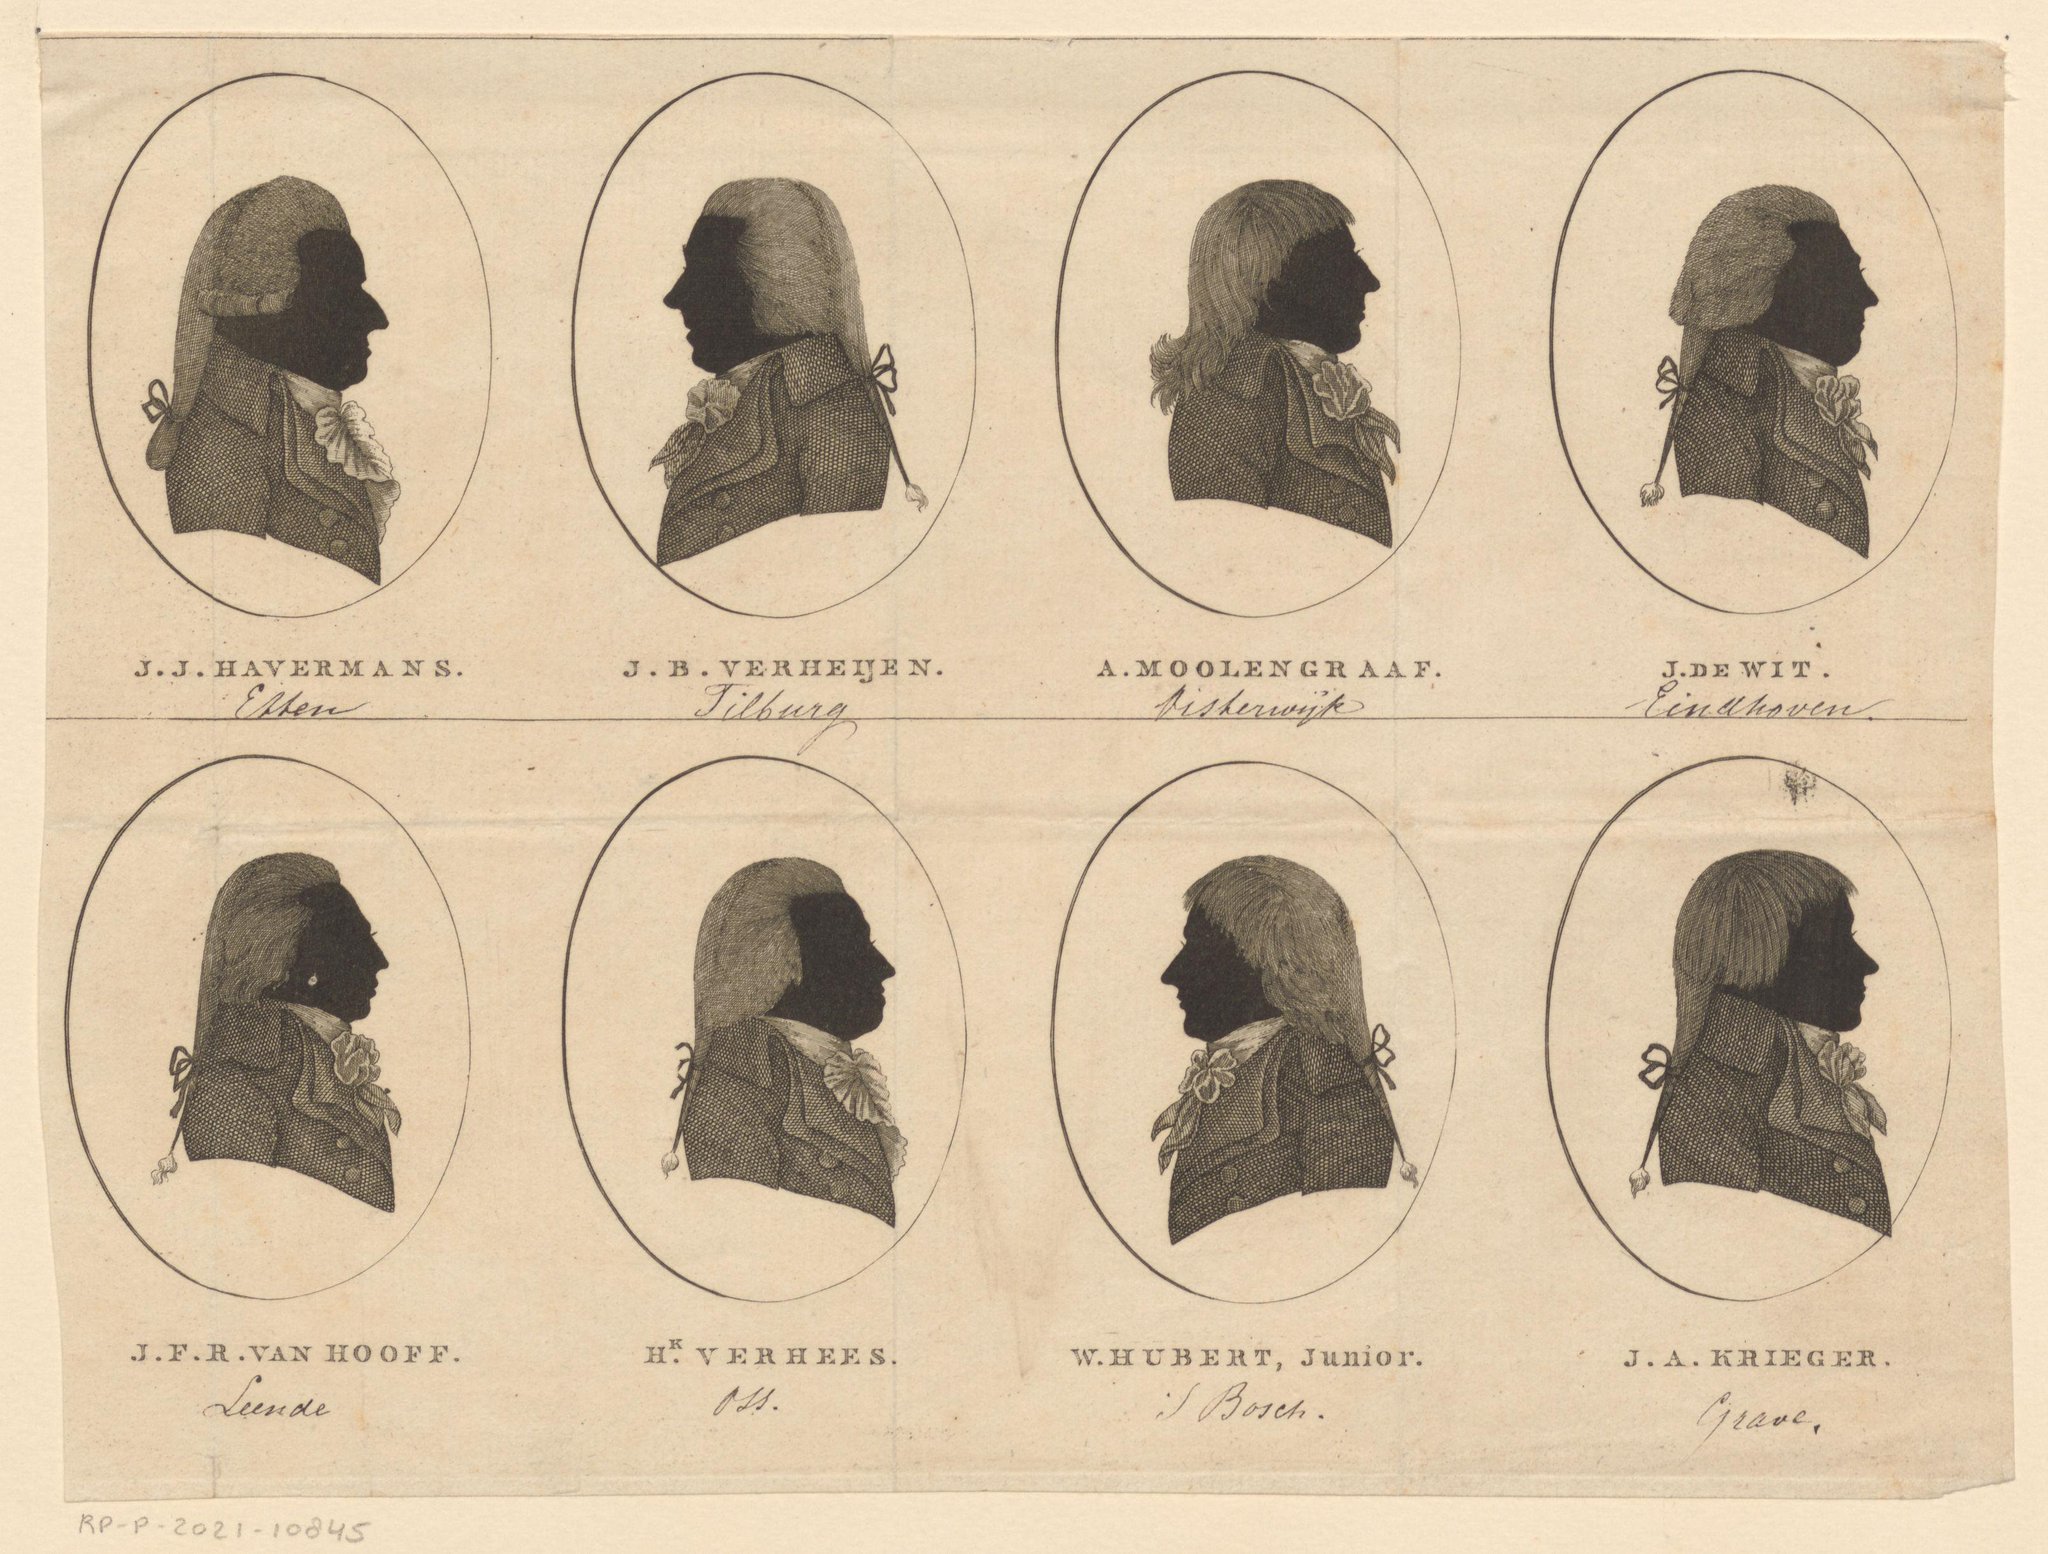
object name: book illustration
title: Silhouetportretten van acht politici uit Brabant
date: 1799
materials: paper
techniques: etching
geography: amsterdam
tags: historical persons, politician, e.g. party leader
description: Prent uit: Rogge, Cornelis. Geschiedenis der staatsregeling, voor het Bataafsche volk. Amsterdam: Johannes Allart, 1799.